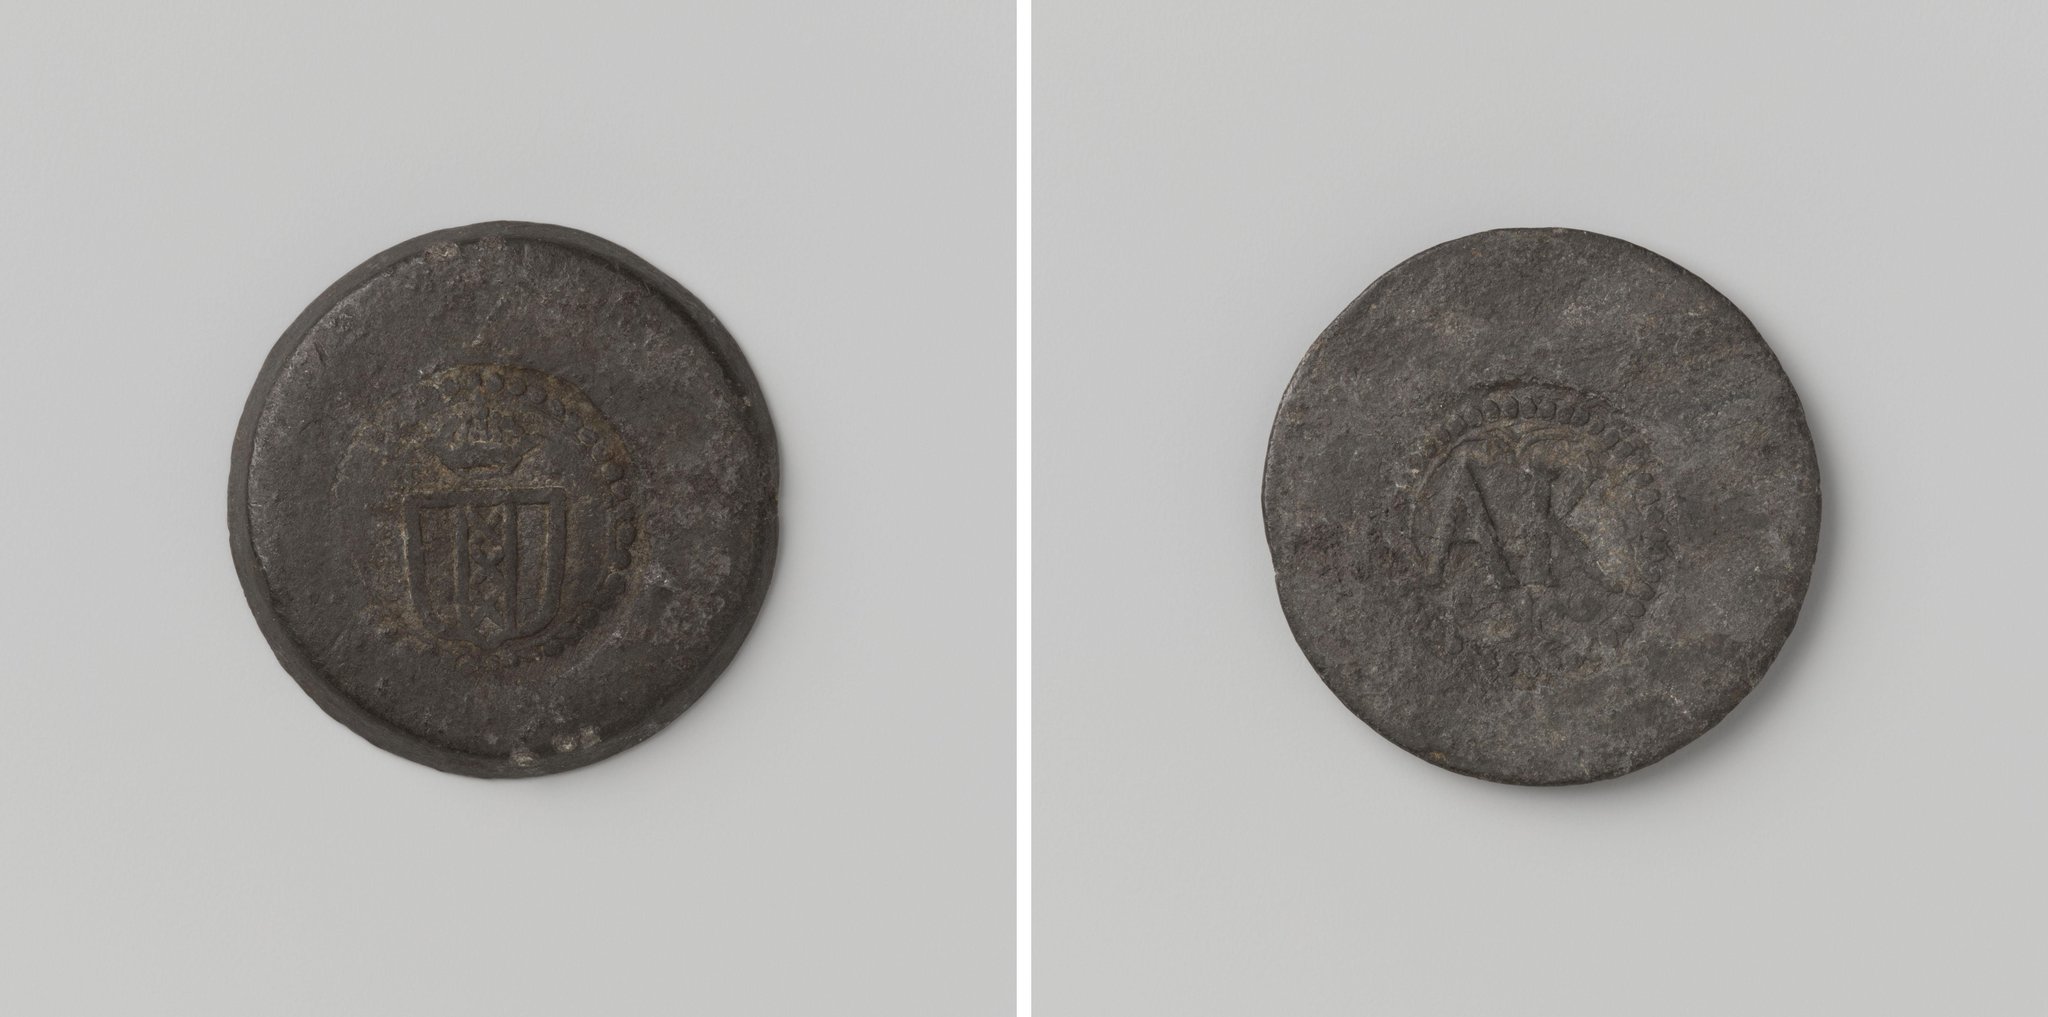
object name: alms token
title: Stad Amsterdam, armenpenning met opschrift AK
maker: Anonymous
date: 1600-1800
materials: lead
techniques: casting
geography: amsterdam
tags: amsterdam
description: Loden penning. Voorzijde: in ronde parelcirkel: gekroond wapenschild. Keerzijde: in ronde parelcirkel: monogram van letters A en K